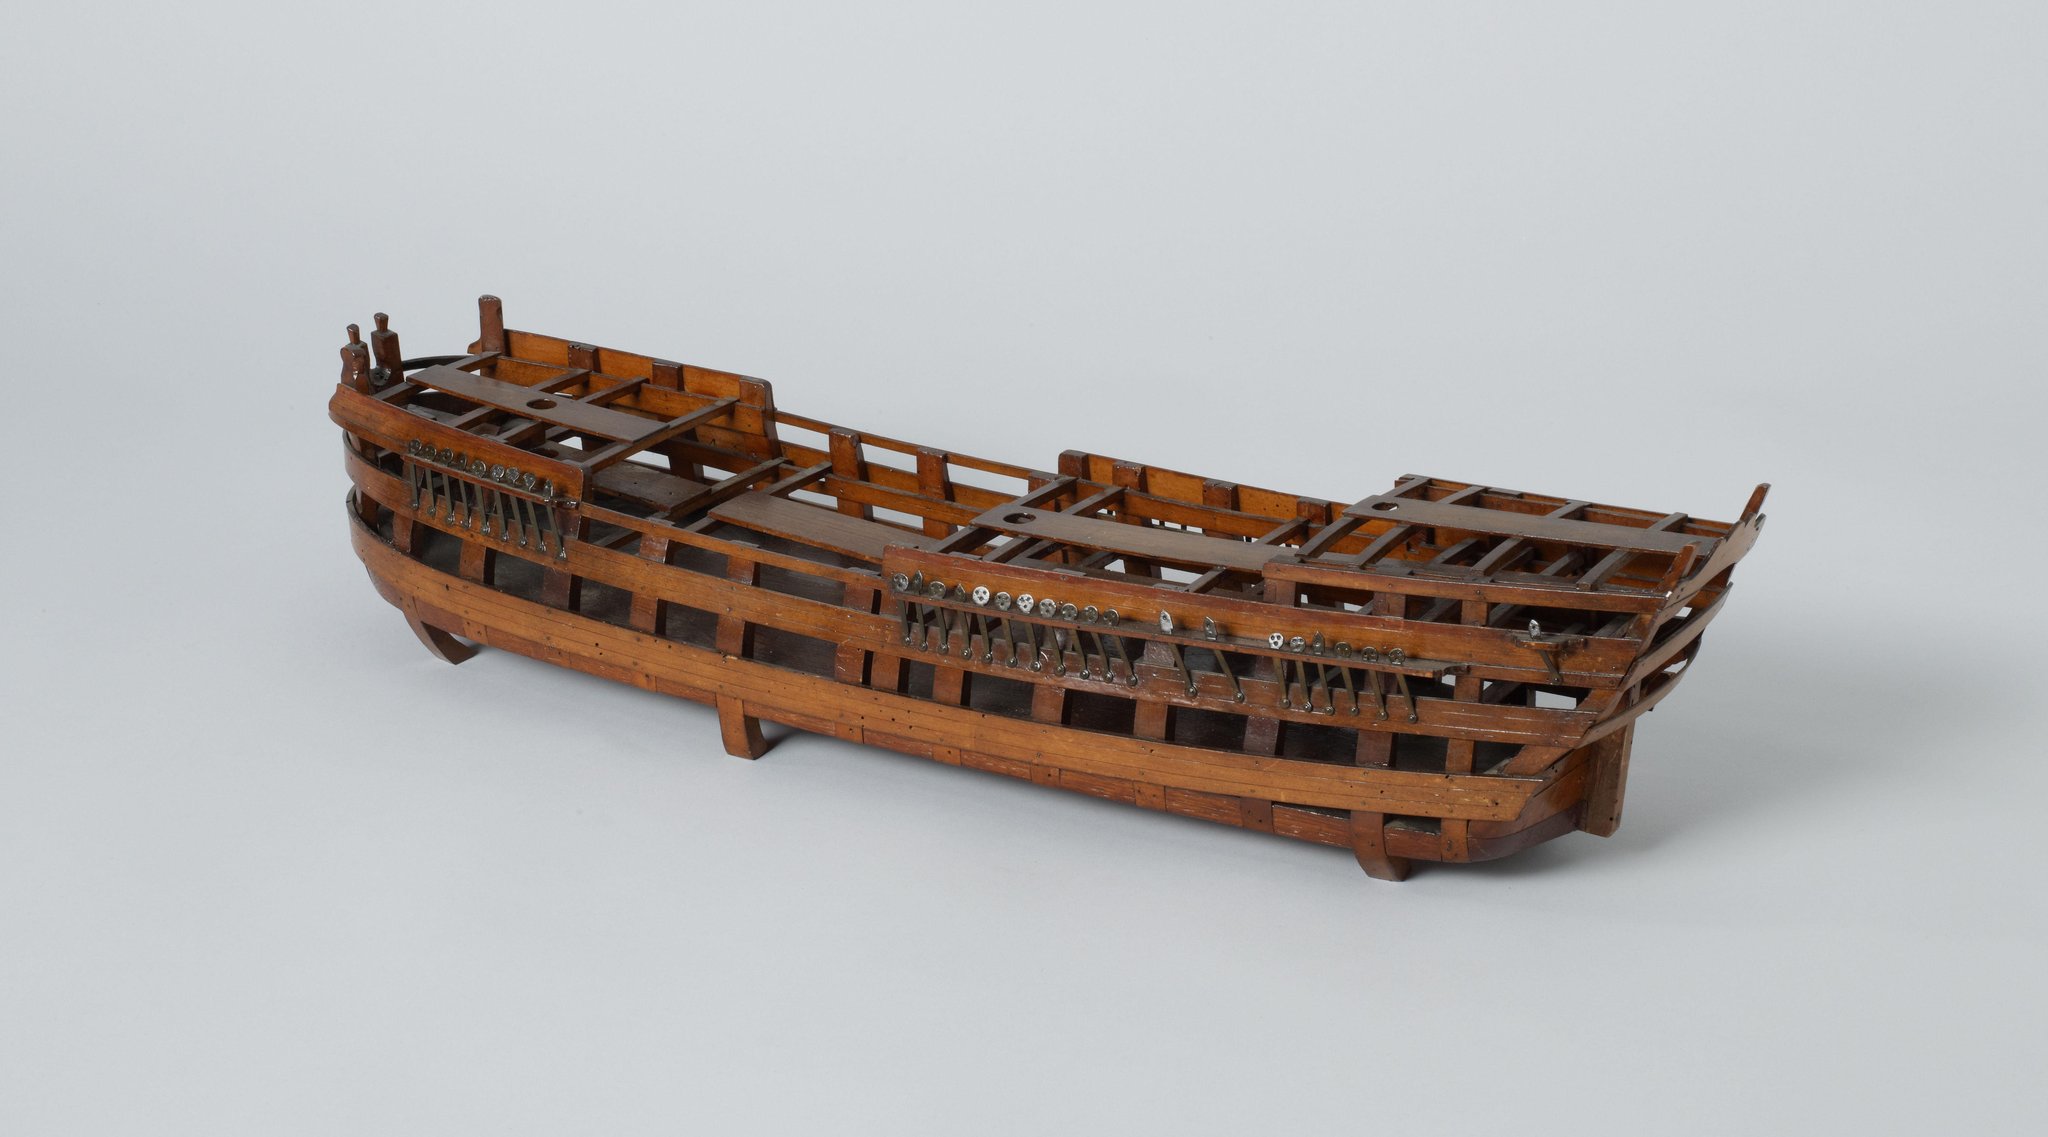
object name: ship model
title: Model of a Three-Masted Ship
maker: Anonymous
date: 1780-1820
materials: brass, wood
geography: netherlands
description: Waterlijn- en constructiemodel van een driemaster. De romp heeft geen huid en bestaat slechts uit de voornaamste inhouten. Het model heeft vier niveau's: onderdek, hoofddek, bovendek (halfdek en bak), en bovencampanje, geen van alle gesloten. Achterschip met gewrongen spiegel, hol wulf, geen details van hek behalve de constructie, geen zijgalerijen. De zeeg loopt een weinig op naar beiden uiteinden, twee barkhouten en één reehout. Het model is ongetuigd; vermeldenswaard is het feit dat de grote en bezaansrust doorlopen.